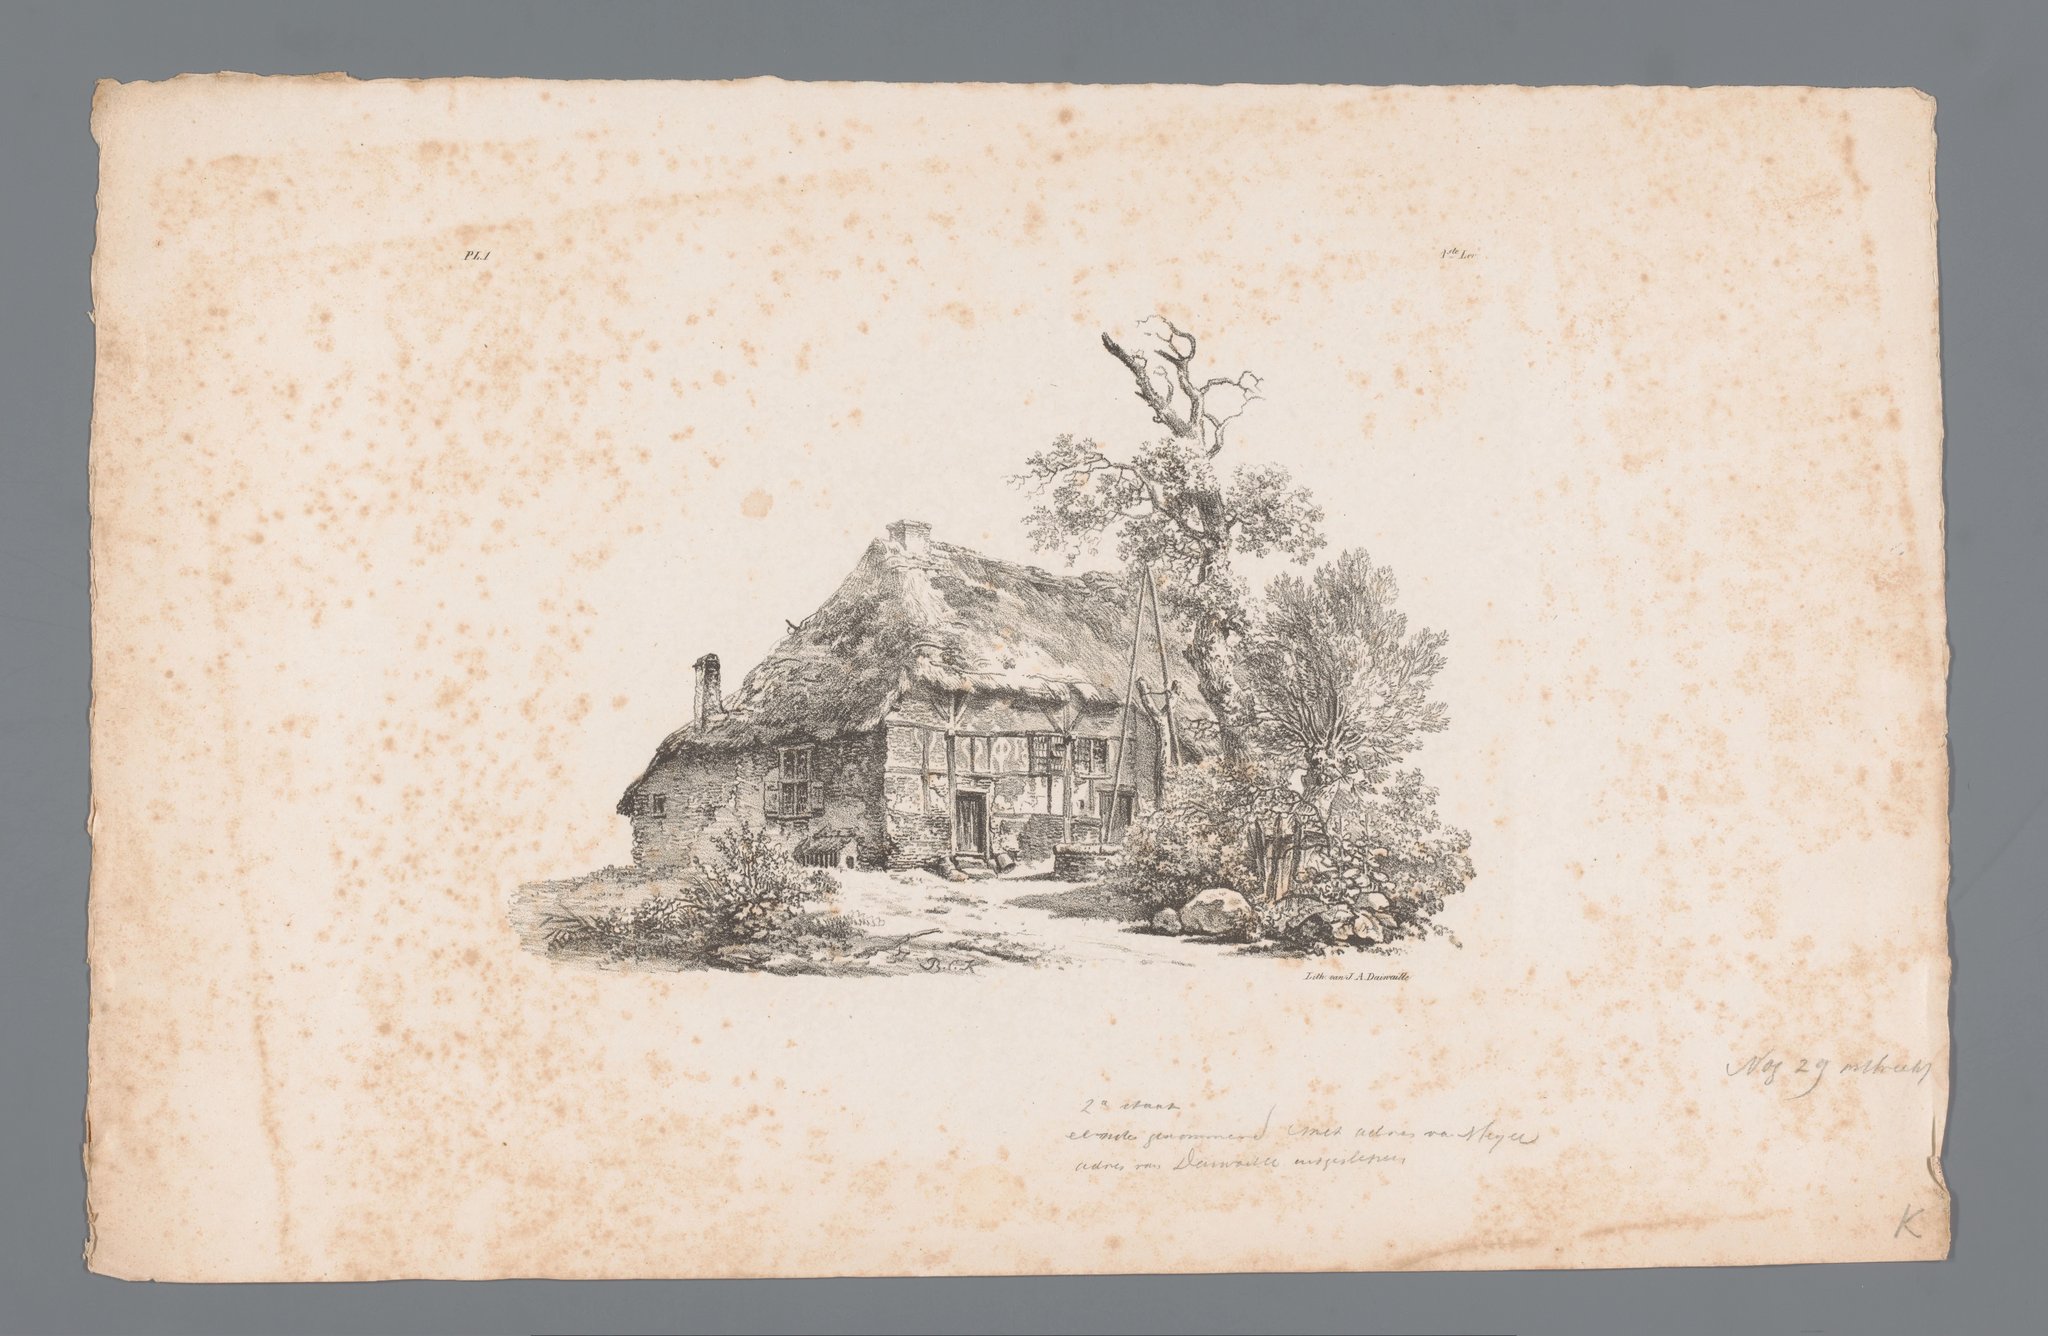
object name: print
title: Landschap studiën eerste levering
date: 1829-1830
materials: paper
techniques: lithograph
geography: amsterdam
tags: well, farm (building)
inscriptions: collector's mark: Lugt 2228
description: In 1829 en 1830 gaf Koekkoek, samen met Daiwaille, zes cahiers uit met ieder zes prenten getiteld Landschapstudiën. Deze werden gebruikt in het tekenonderwijs. Vijftien jaar later werd deze reeks, in een andere samenstelling nogmaals uitgegeven door Meyer en Comp in Amsterdam. Zie: De Bruyn Kops, 1963.